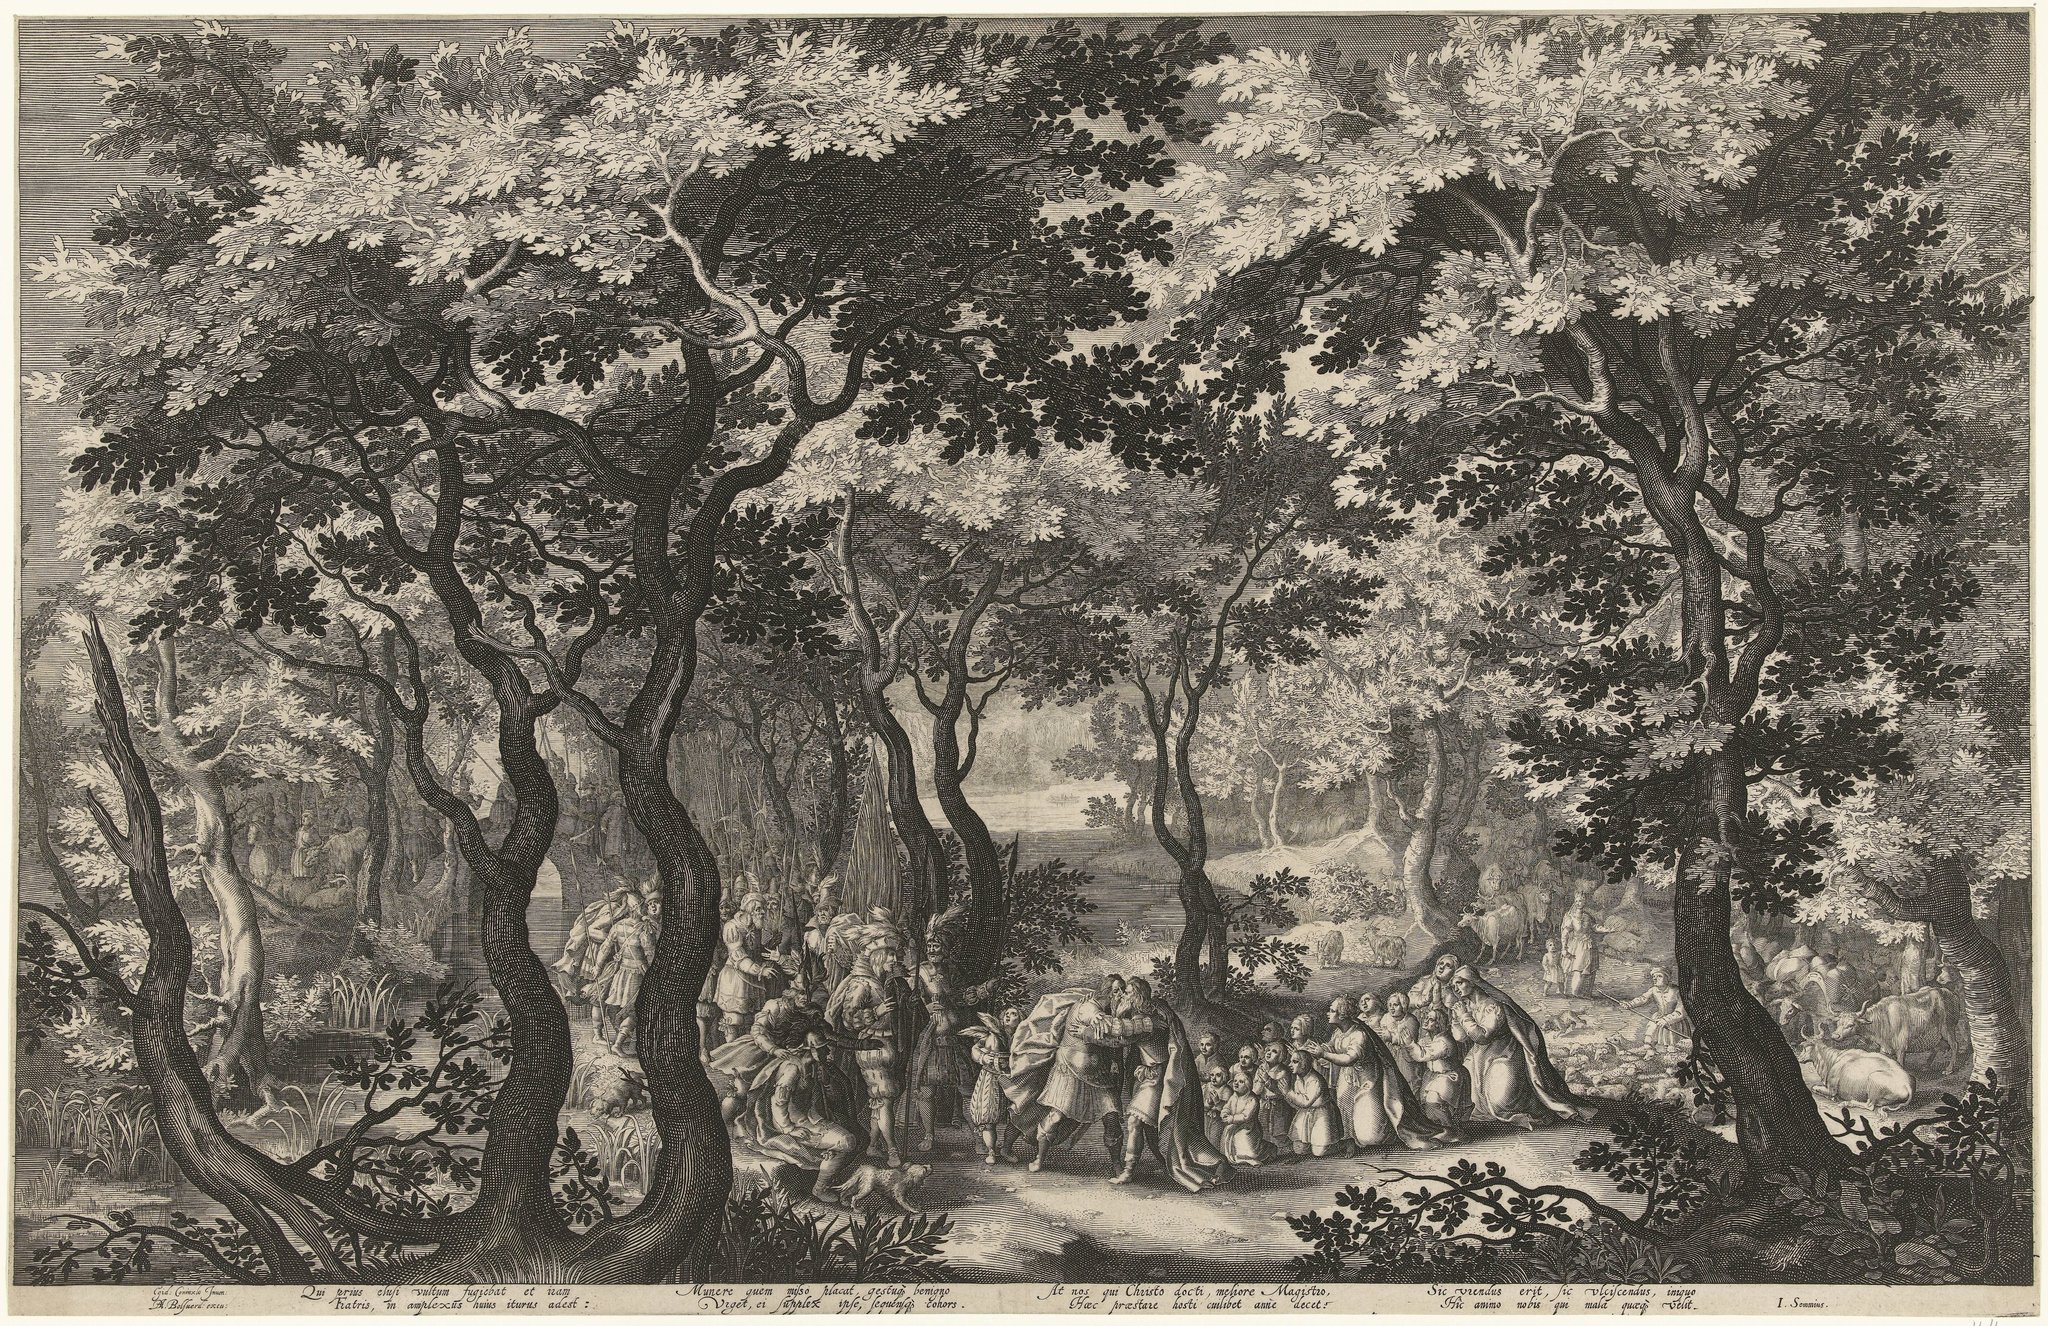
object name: print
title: Landschap met ontmoeting van Jacob en Esau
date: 1590-1633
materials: paper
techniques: engraving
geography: netherlands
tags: the meeting between esau and jacob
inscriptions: collector's mark: Lugt 2228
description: Prent naar ontwerp van Gillis van Coninxloo. In de collectie van het RMA bevinden zich twee staten maar het is onduidelijk hoe deze zich tot elkaar verhouden (vergelijk RP-P-OB-67.490).